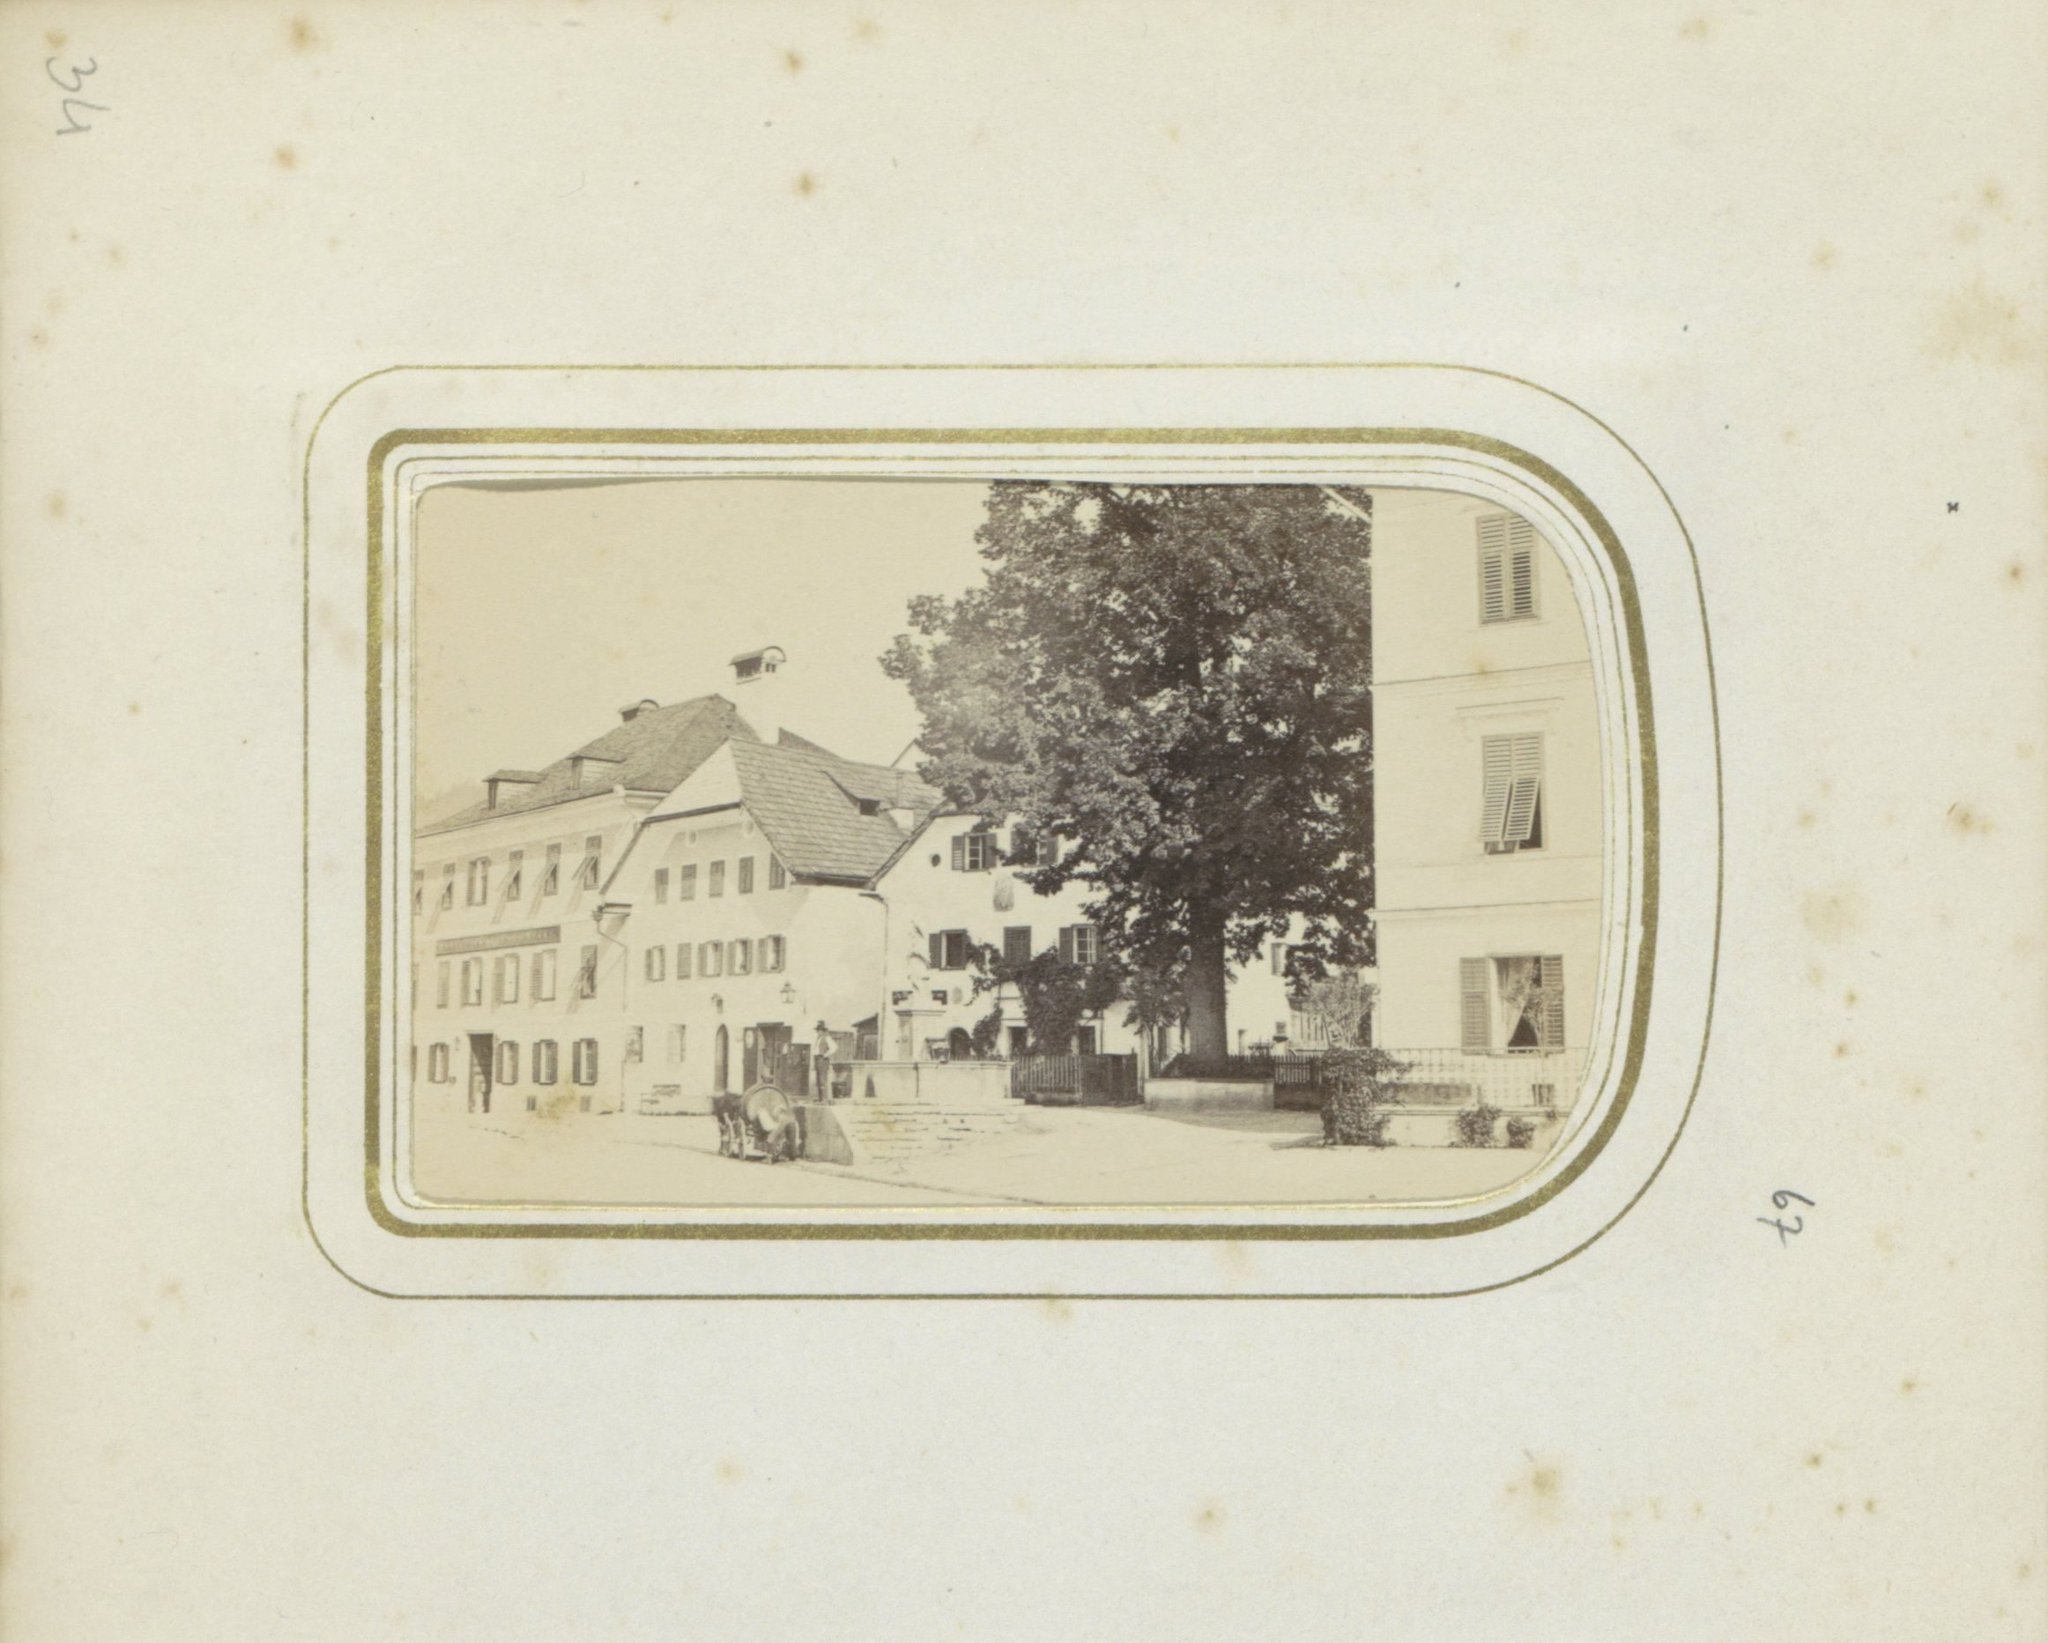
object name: photograph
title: Exterieur van Hotel zum Goldenen Kreuz in Ischl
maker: Anonymous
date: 1865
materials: paper, photographic support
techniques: albumen print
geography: ischl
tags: travelling; tourism, street, hotel, hostelry, inn, (farm) wagon, freight wagon, cart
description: Onderdeel van Fotoalbum van een reis door Zwitserland, Oostenrijk en Duitsland door de Nederlandse familie Derkinderen.